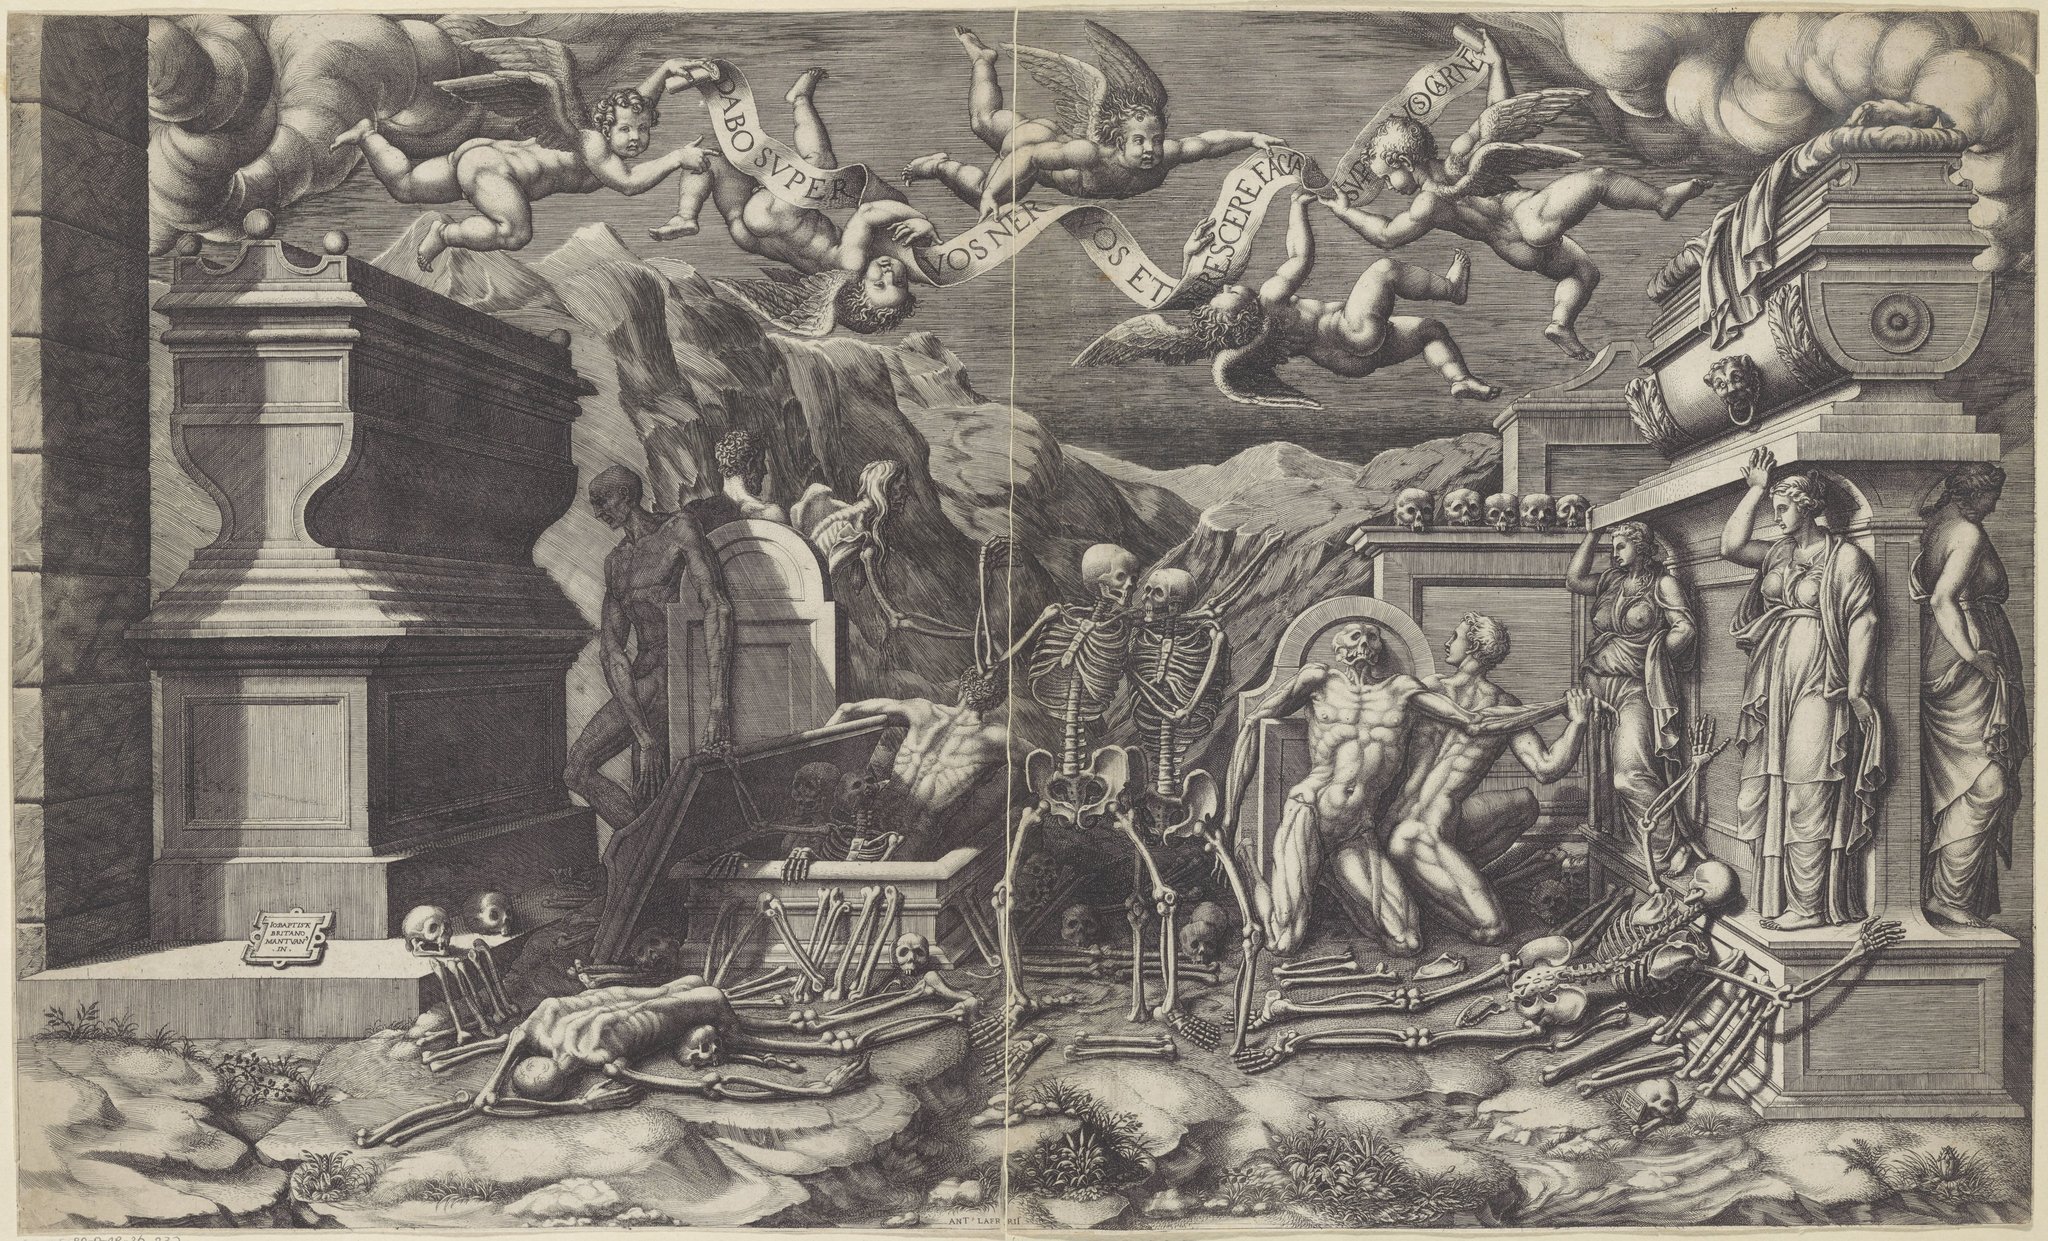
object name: print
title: Visioen van Ezechiël over het dal van beenderen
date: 1530-1582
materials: paper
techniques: engraving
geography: rome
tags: ezekiel's vision of the valley of the dry bones (ezekiel 37:1-10)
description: De profeet Ezechiël heeft een visioen van het dal vol dorre beenderen die met vlees worden bekleed en tot leven komen. Verschillende sarcofagen en grafzerken verspreid door de voorstelling. Boven zweven vijf putti die samen een baderon vasthouden met de tekst: Dabo super vos ner vos et succrescere facia sup vos carne.